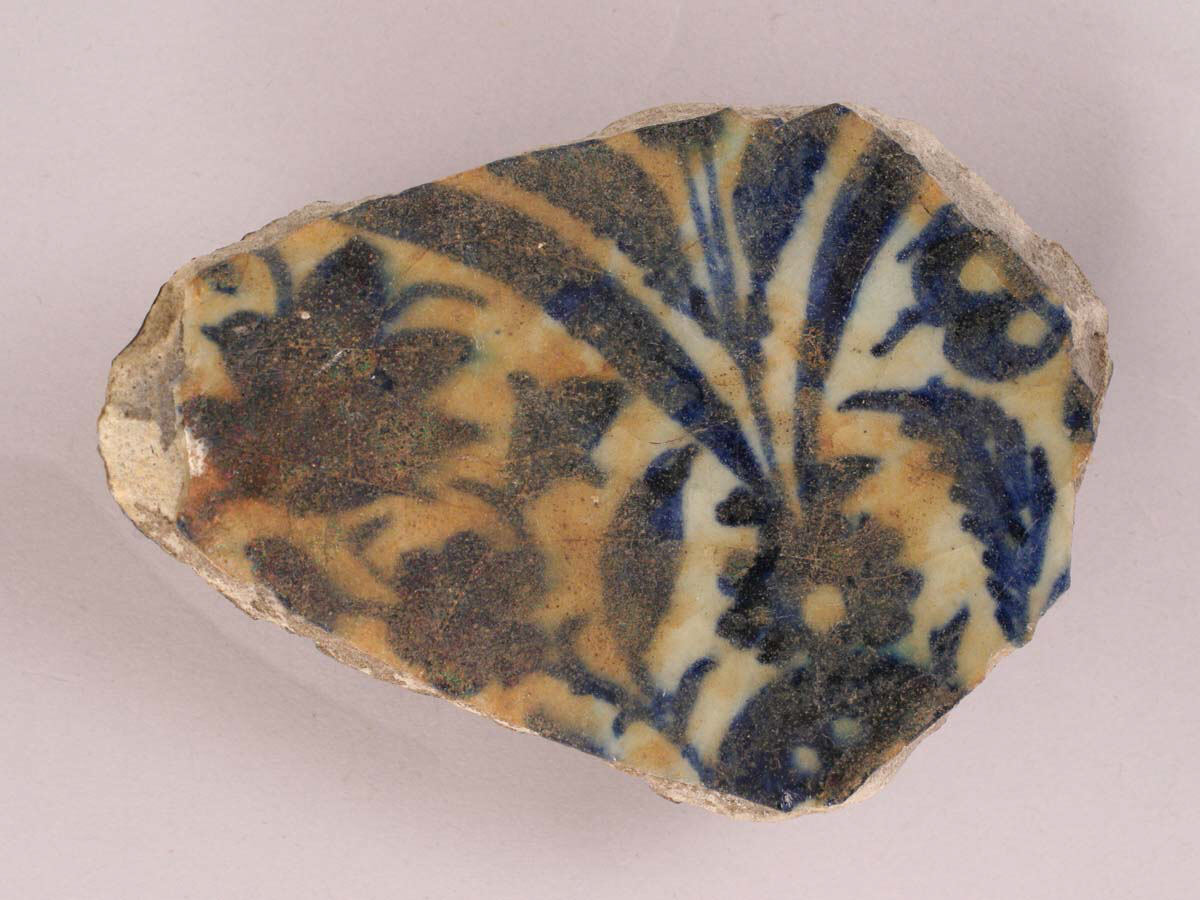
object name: fragment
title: Ceramic Fragment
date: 1301-1400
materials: glaze, stonepaste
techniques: painting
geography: egypt